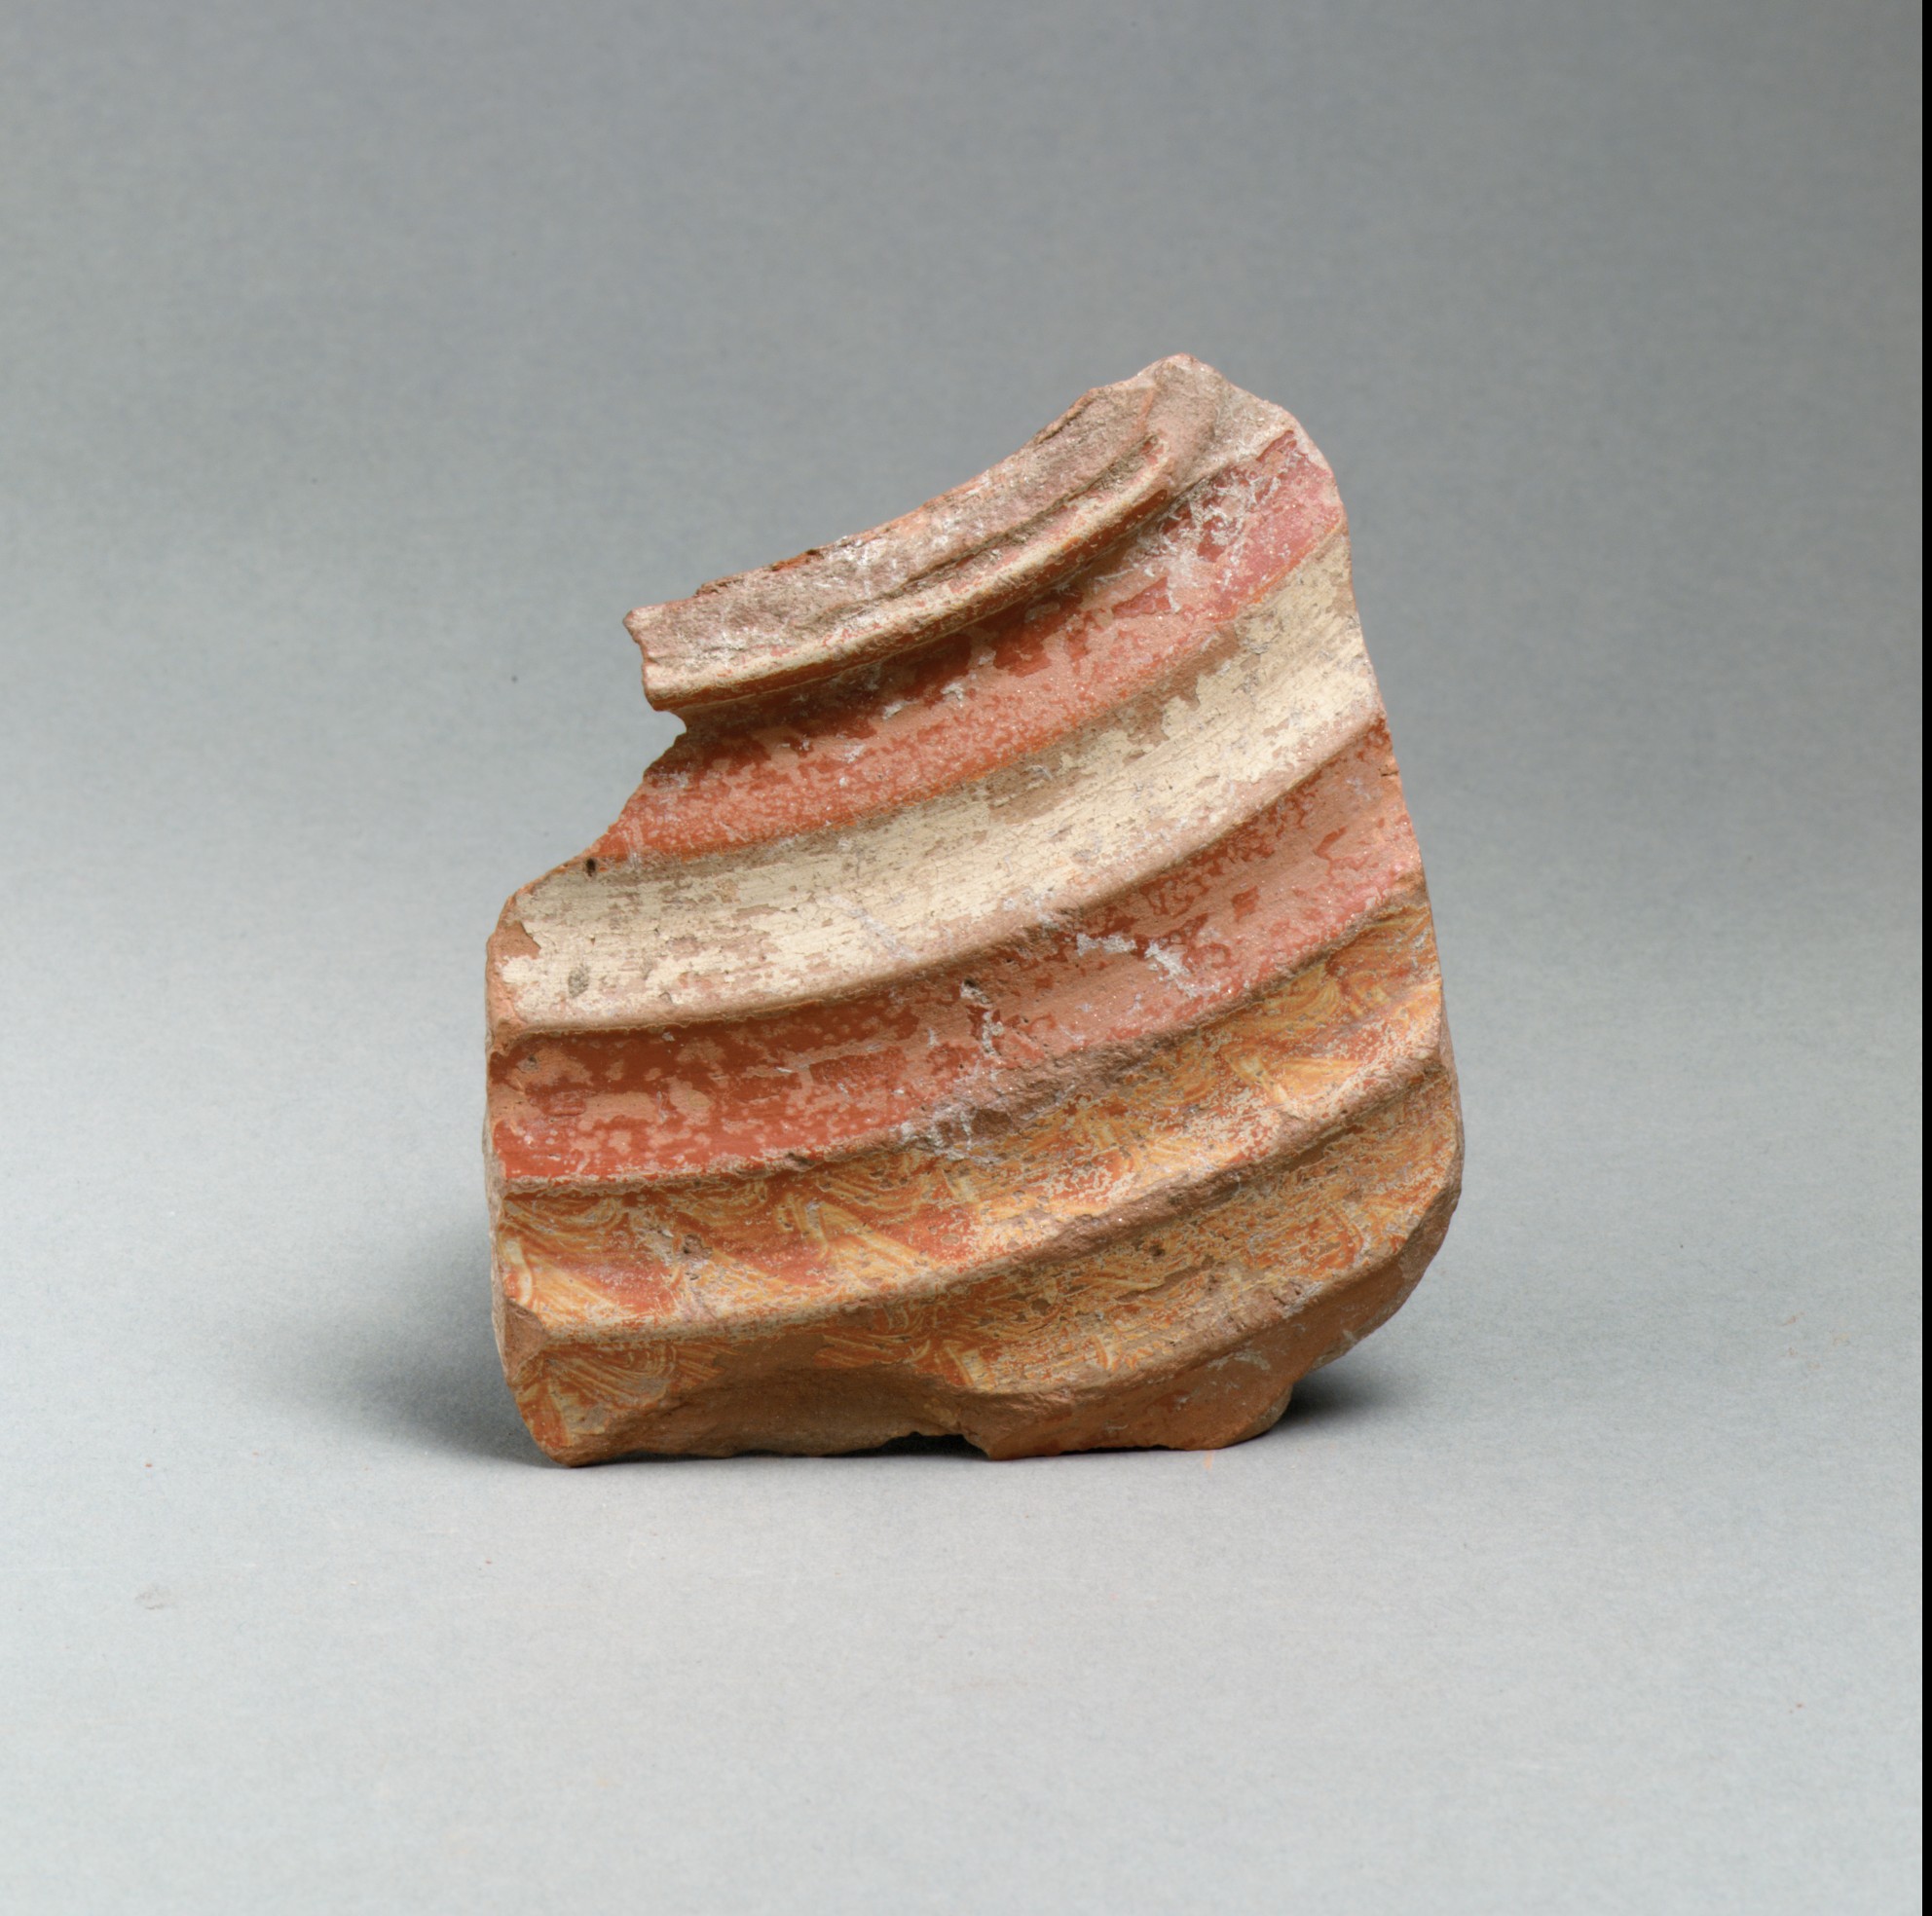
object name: vase fragment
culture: greek or lydian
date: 323 BCE-31 CE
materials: terracotta